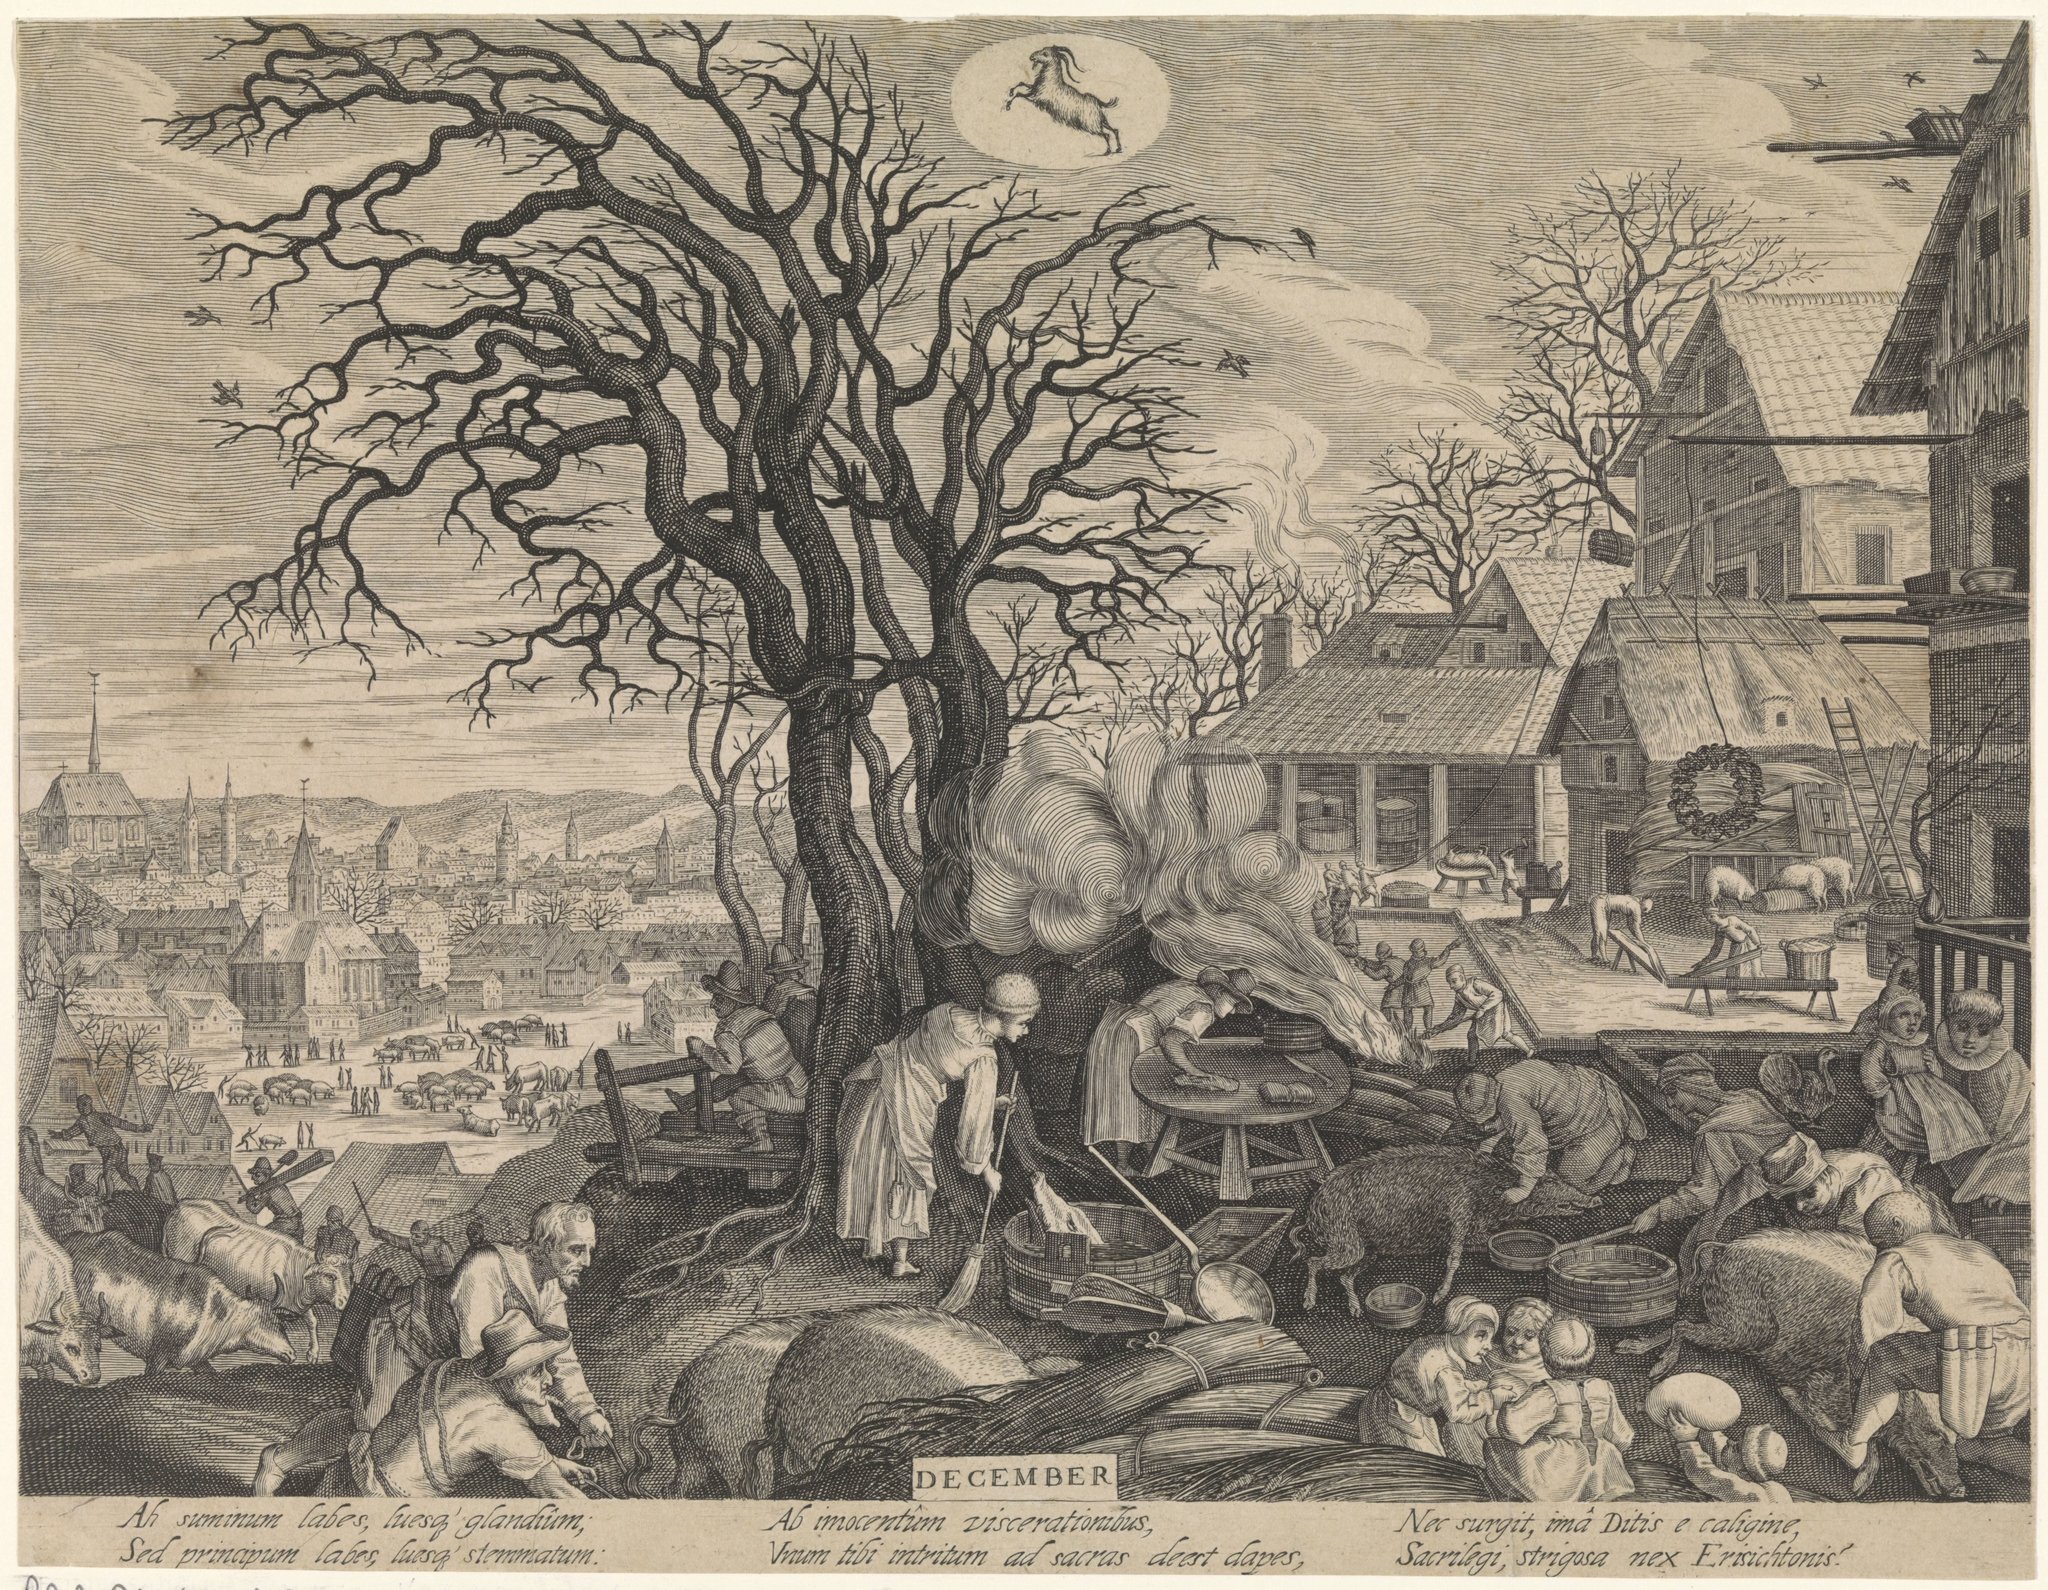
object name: print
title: December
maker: aegidius sadeler (ii)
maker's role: draughtsman, print maker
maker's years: 1568-1629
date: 1607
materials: paper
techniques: engraving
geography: prague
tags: slaughtered ox or pig, conserving, preserving, e.g.: canning, december and its 'labours' (+ with zodiacal signs)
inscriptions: collector's mark: Lugt 712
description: December is de slachtmaand. Centraal staat het slachten van vee en het pekelen van vlees. Middenboven het sterrenbeeld Steenbok. De prent heeft een Latijns onderschrift.